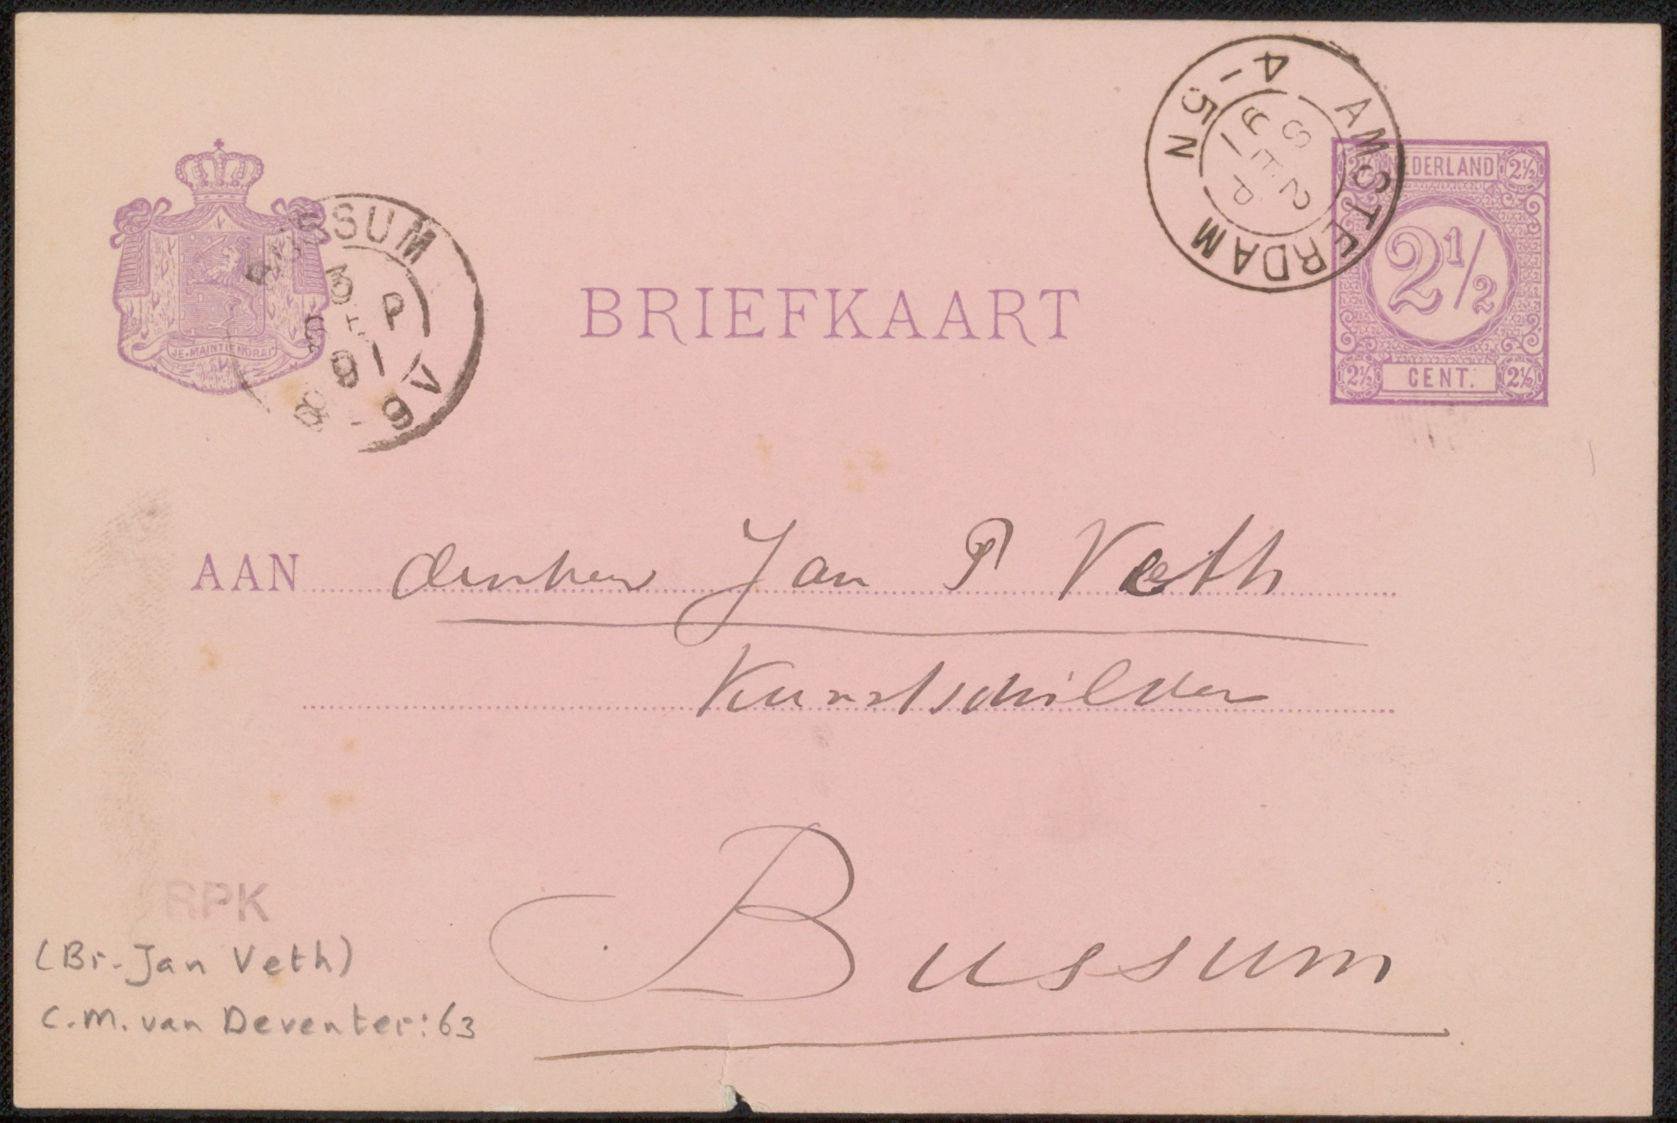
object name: postcard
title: Briefkaart aan Jan Veth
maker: chap van deventer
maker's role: kunstcriticus, scheikundige, schrijver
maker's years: 1860-1931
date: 1891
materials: cardboard, ink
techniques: pen, writing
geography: amsterdam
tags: painter, print maker, draughtsman, designer, jan veth, literature ~ arts, family life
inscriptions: collector's mark: ‘RPK’